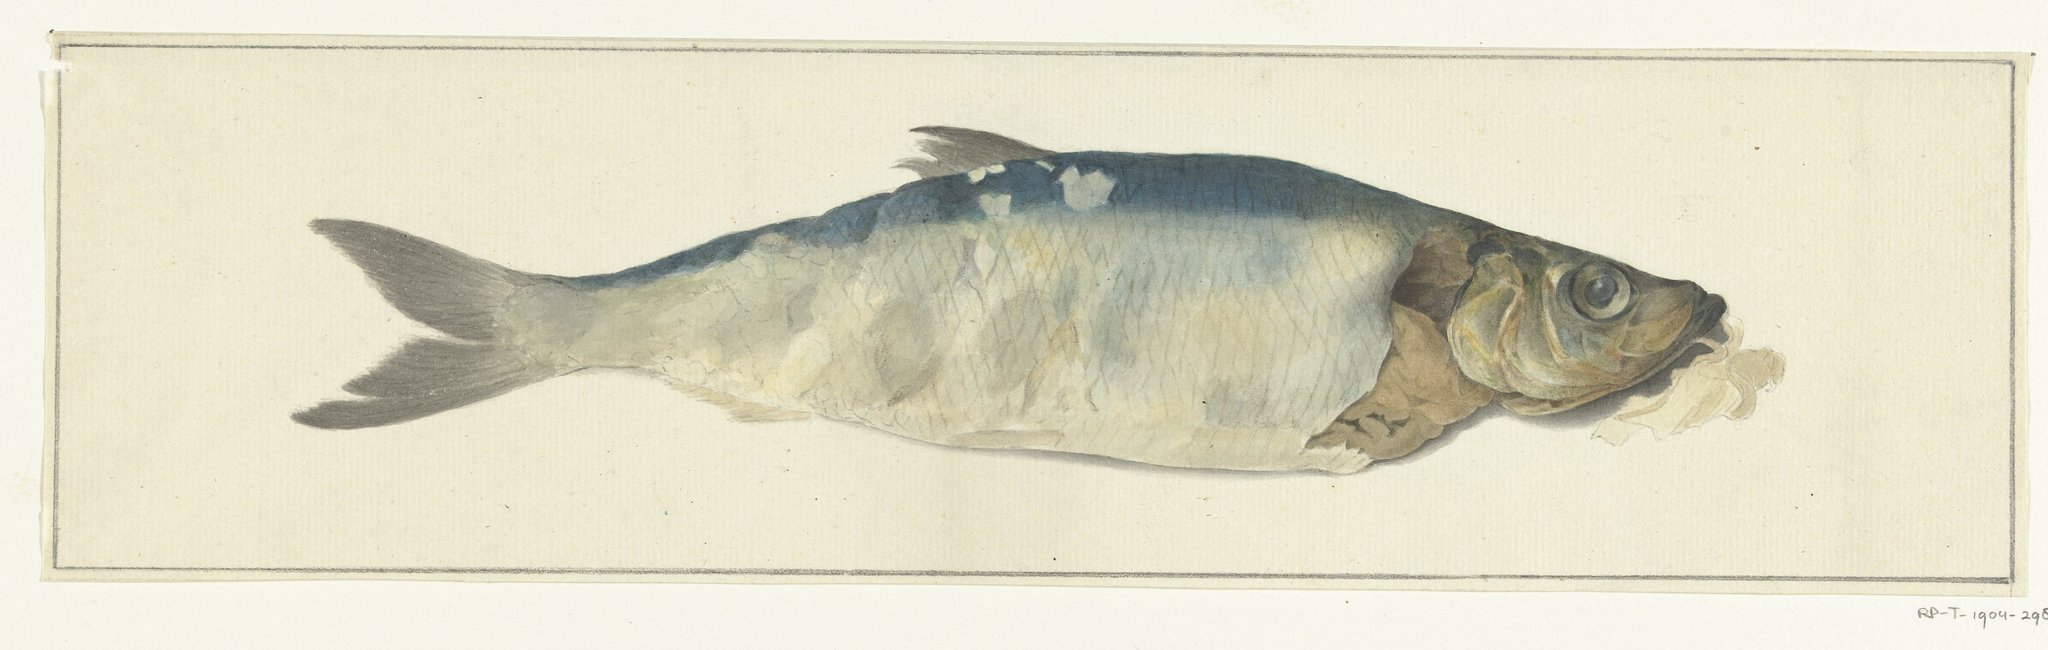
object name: watercolor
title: Vis, deels vergaan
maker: jean bernard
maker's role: draughtsman, print maker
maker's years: 1765-1833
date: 1775-1833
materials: chalk, paper, watercolor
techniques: brush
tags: bony fishes